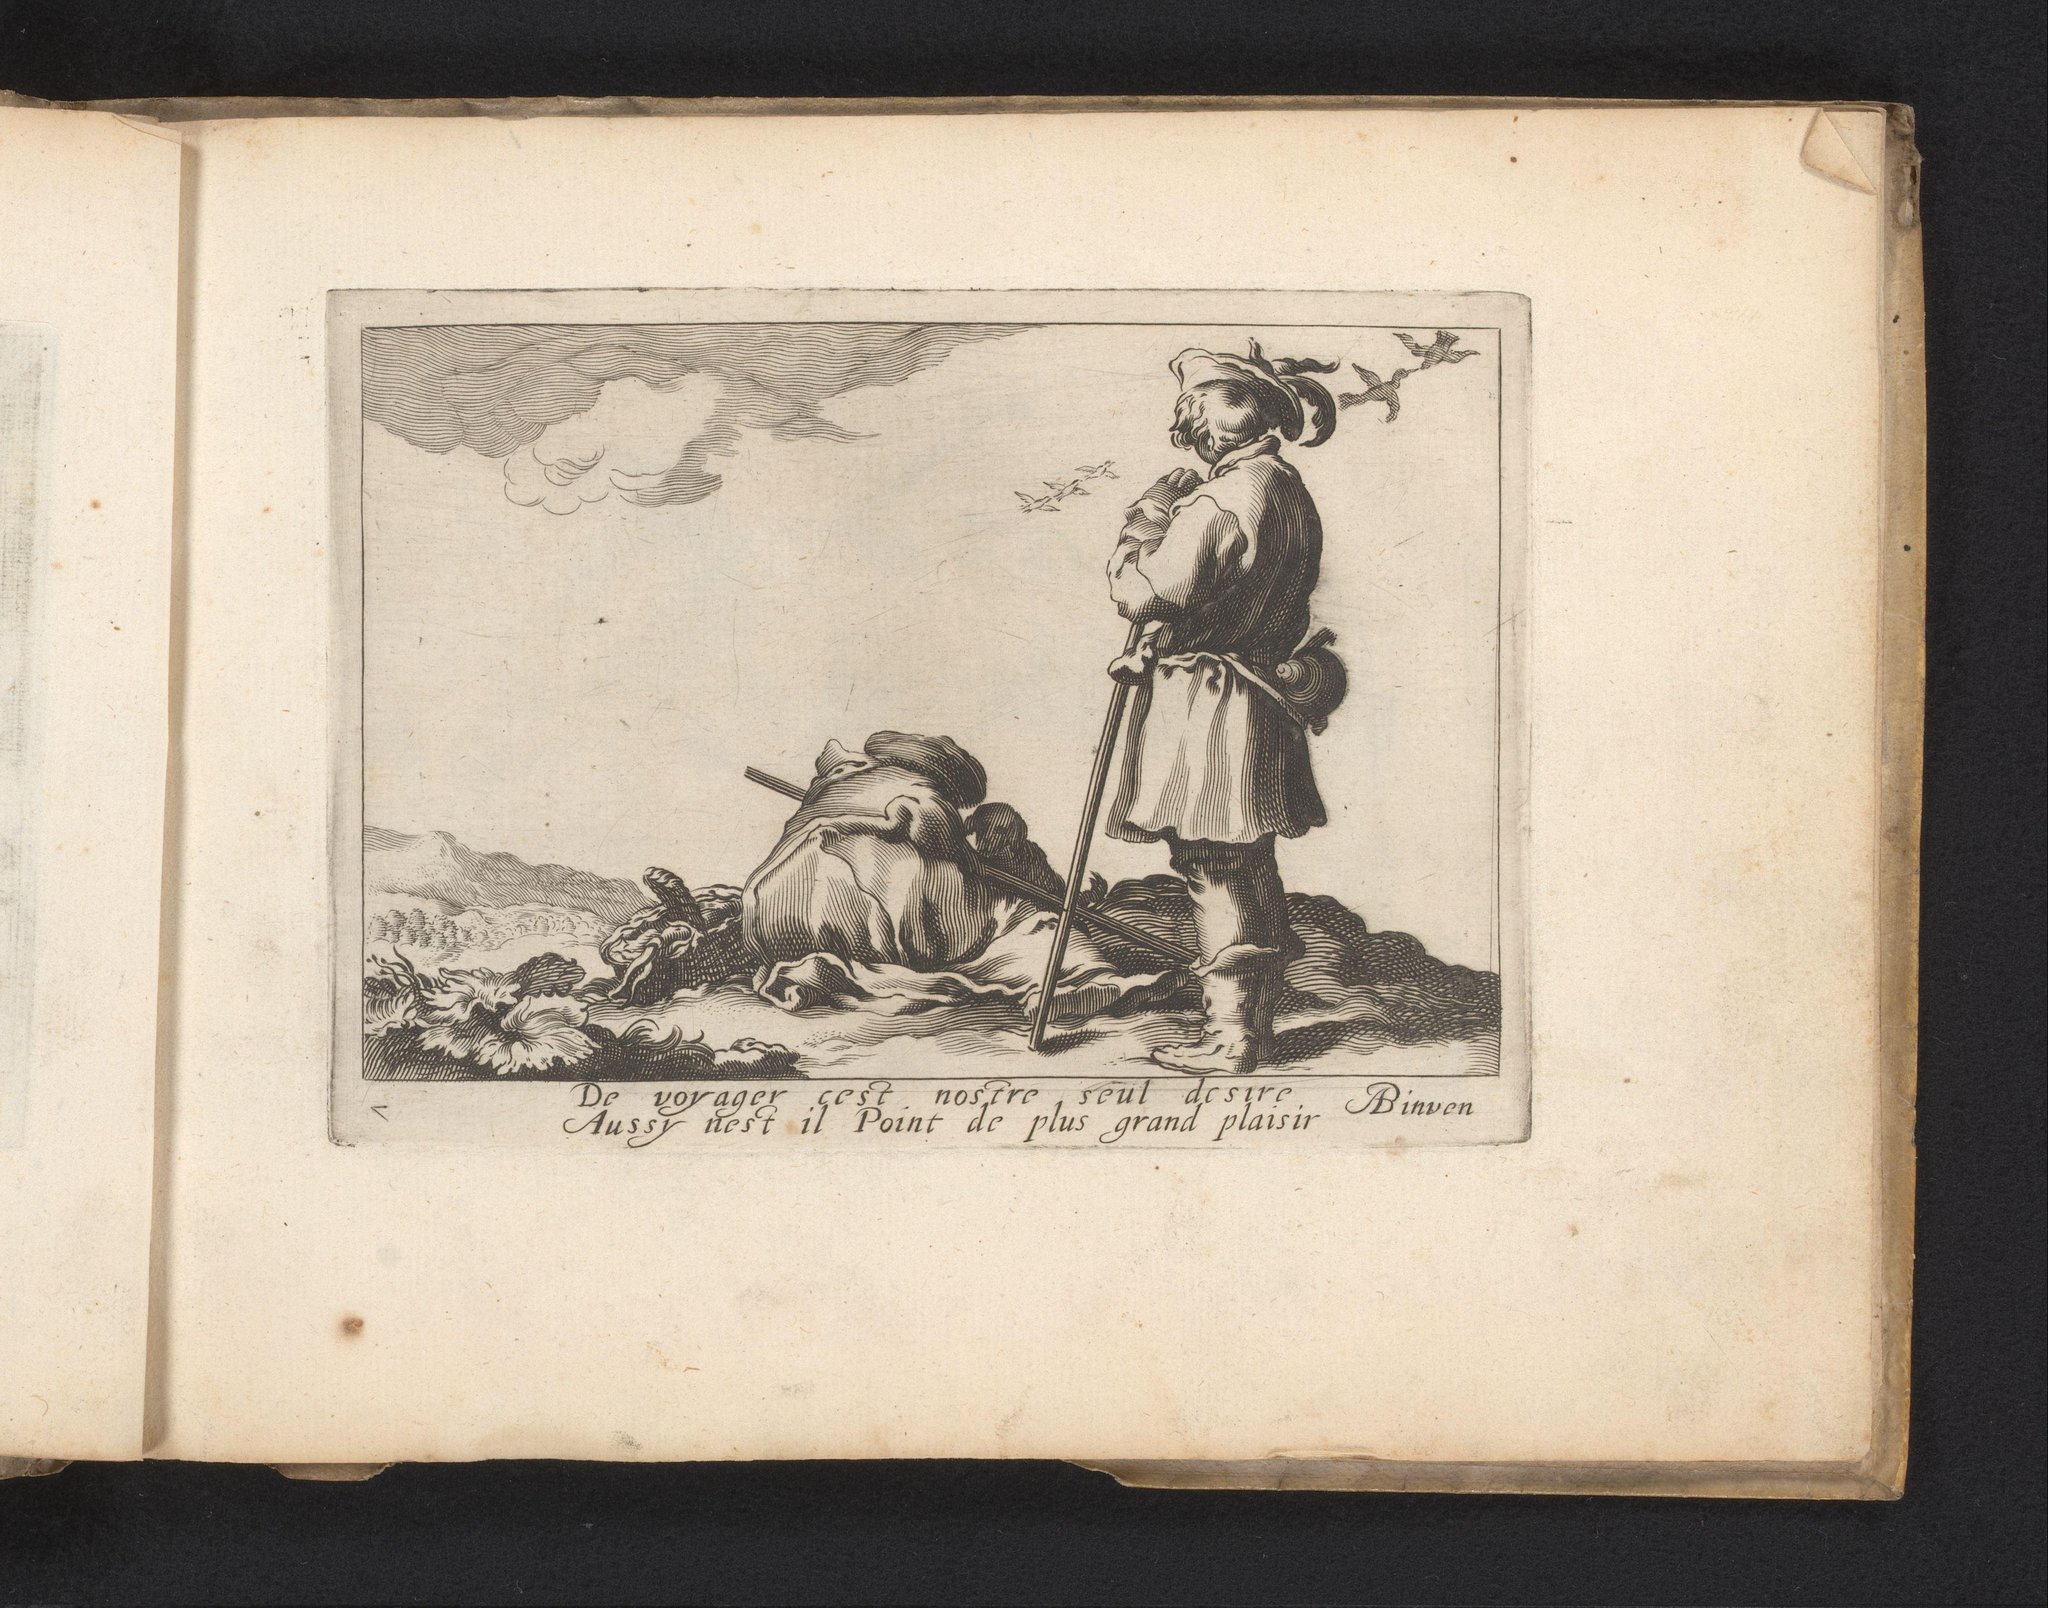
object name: print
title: Staande en zittende figuren in een landschap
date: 1606-1669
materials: paper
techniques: etching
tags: (traveller) resting in the open air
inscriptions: collector's mark: ‘Bibliotheek/ Rijksmuseum/ Amsterdam’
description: Deze prent maakt deel uit van een album.